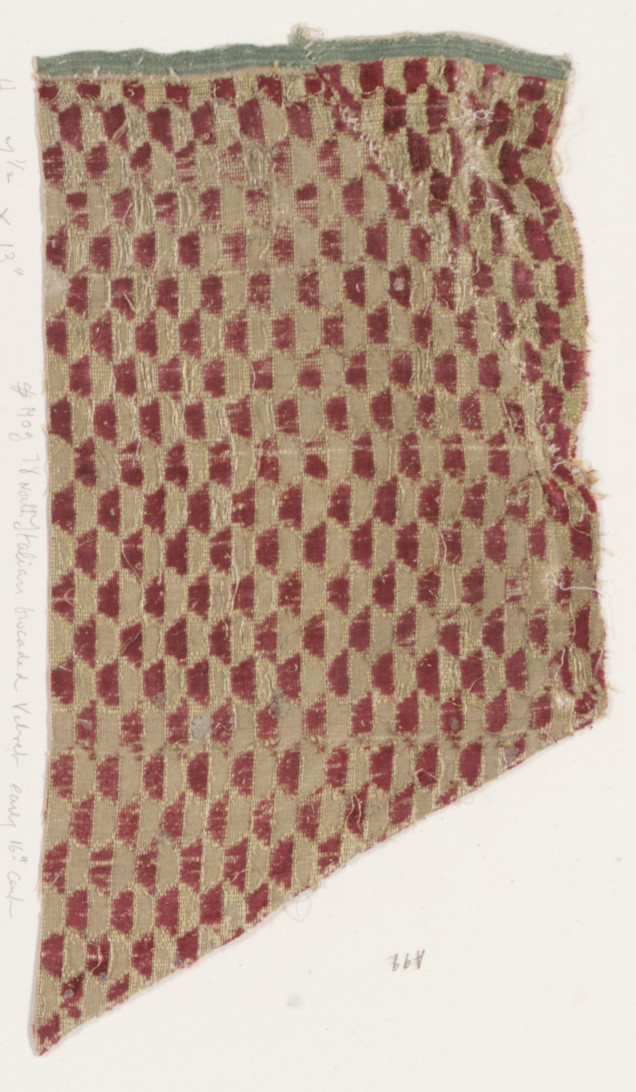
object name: fragment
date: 1501-1533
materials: metal thread, silk